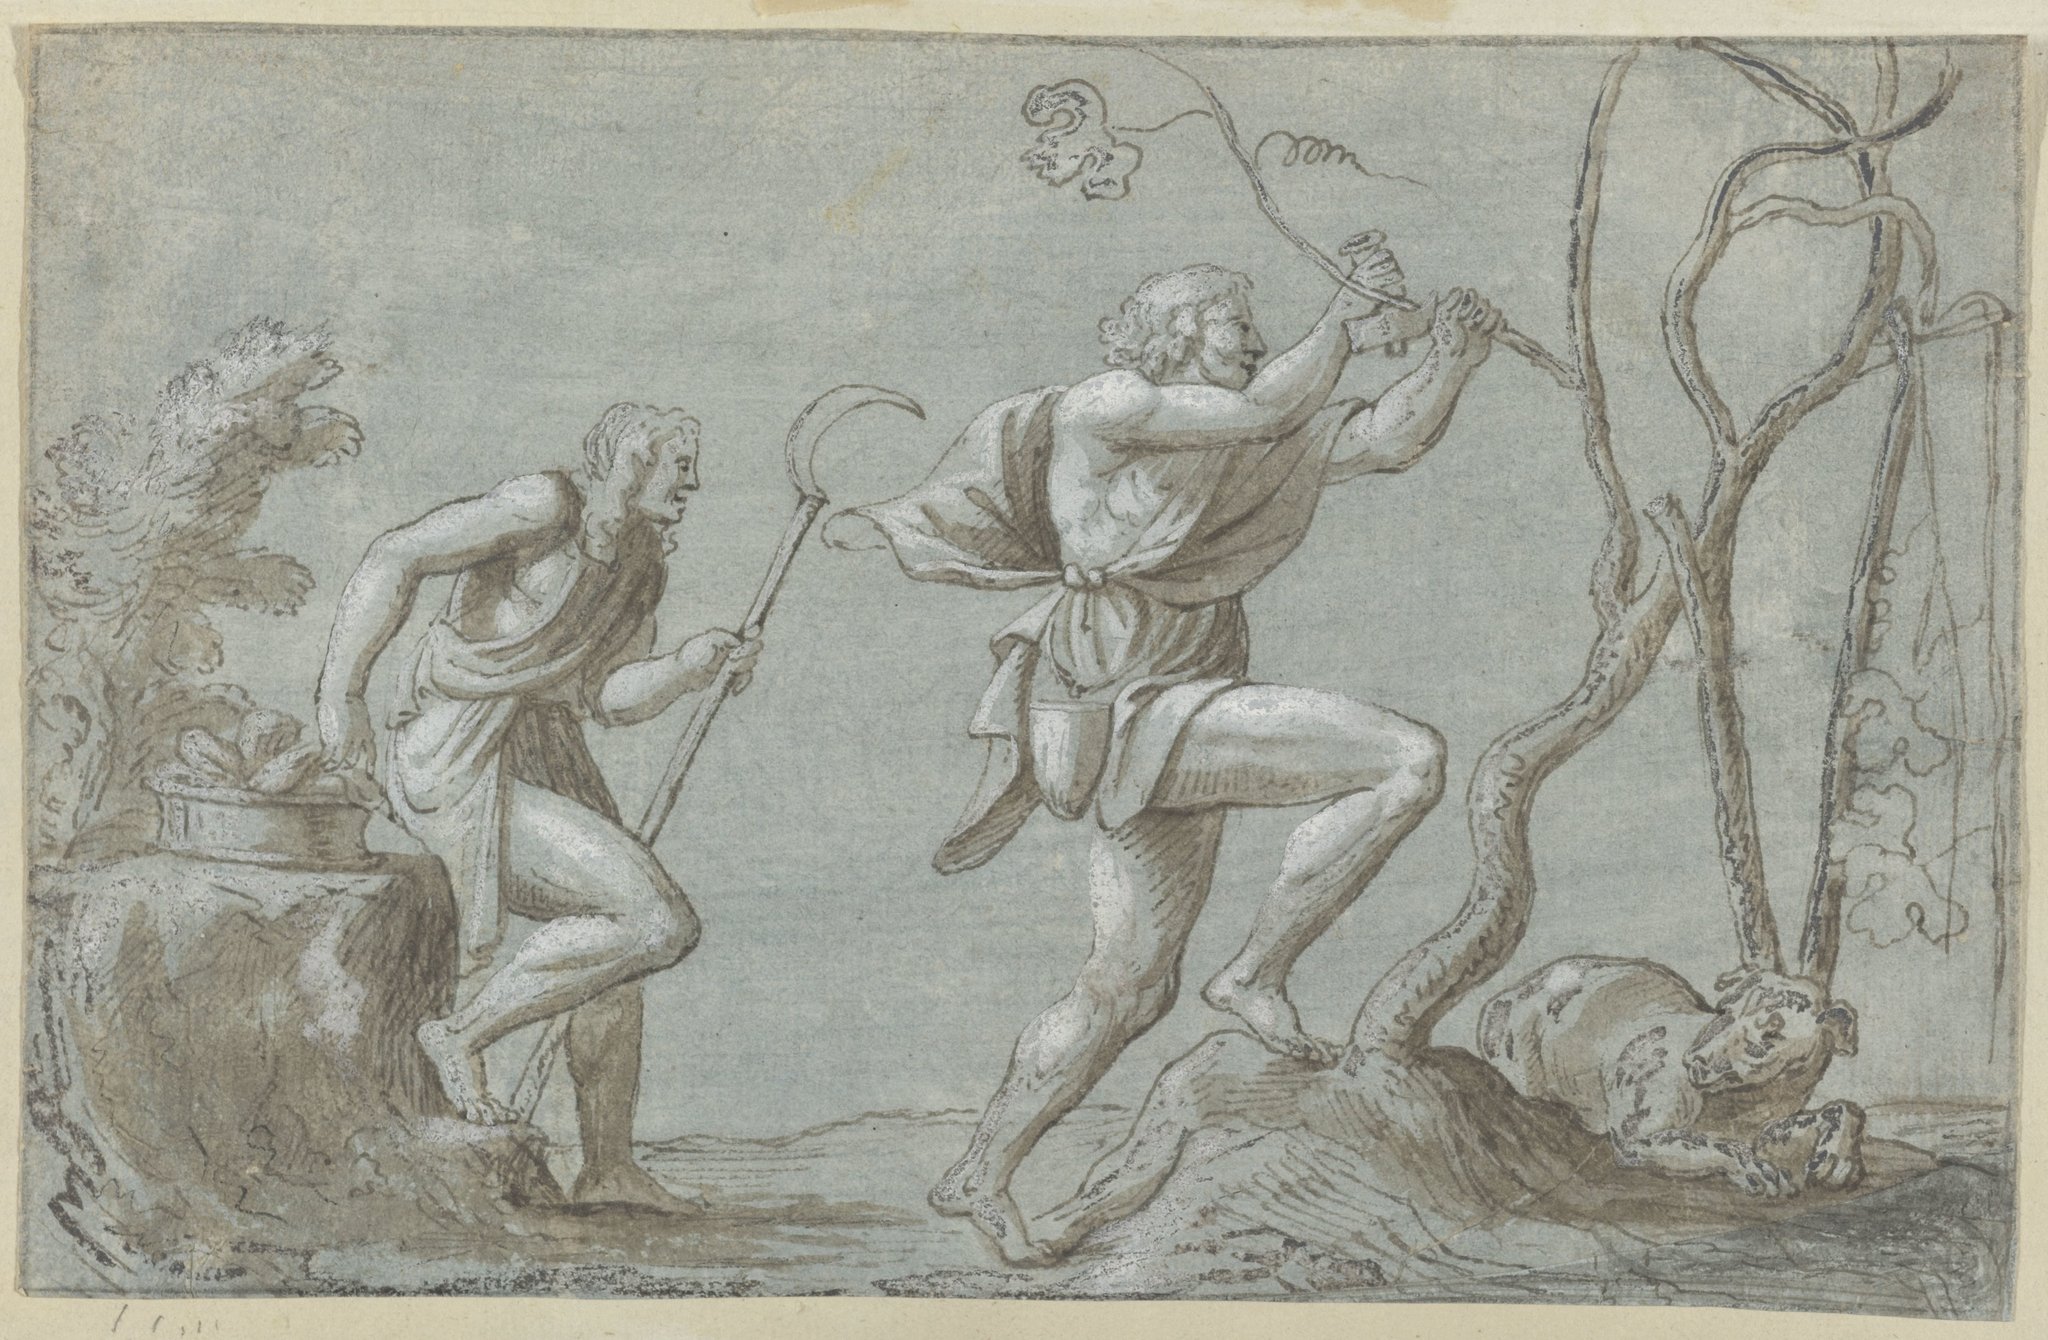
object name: drawing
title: Twee mannen in een landschap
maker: Anonymous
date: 1700-1799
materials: paint, ink, paper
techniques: brush, pen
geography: netherlands